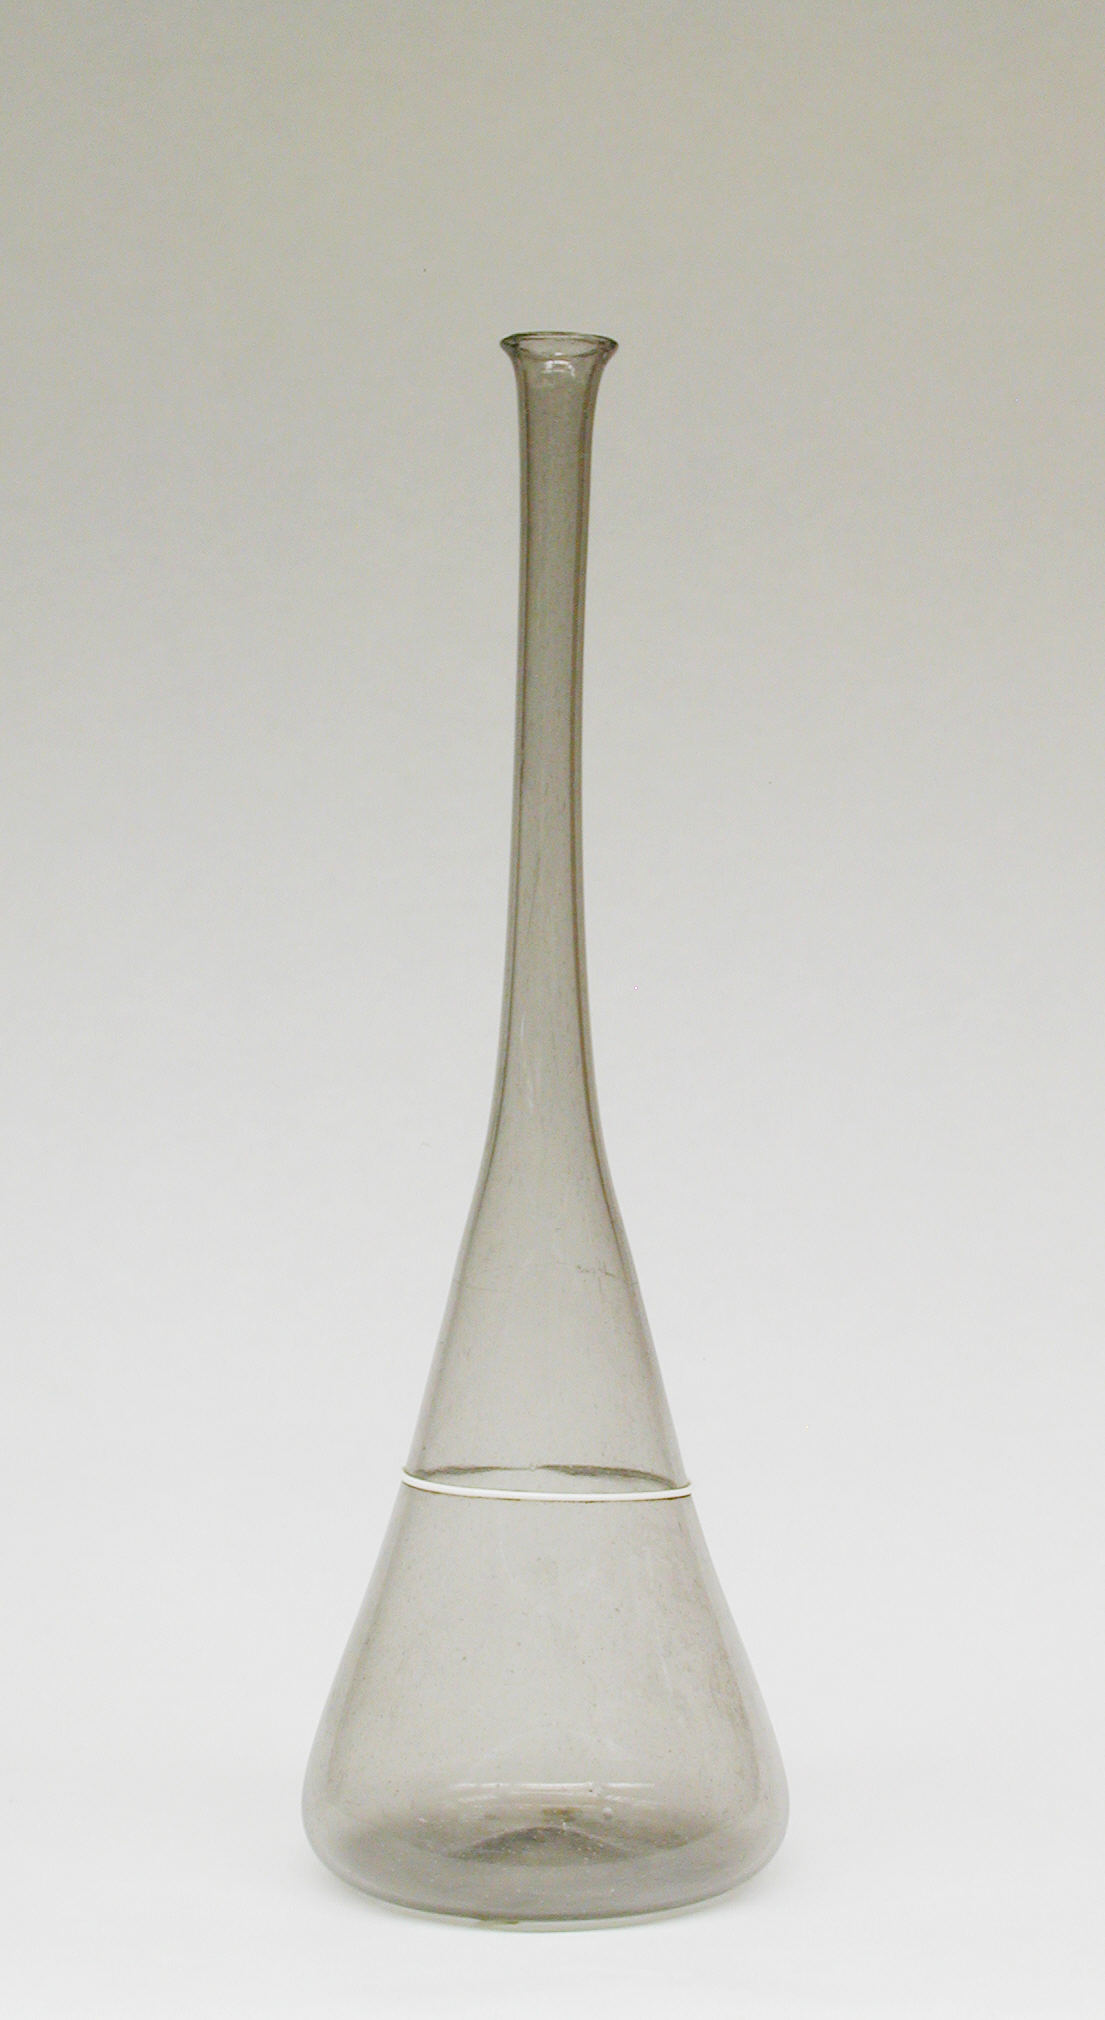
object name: bottle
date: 1501-1600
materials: glass